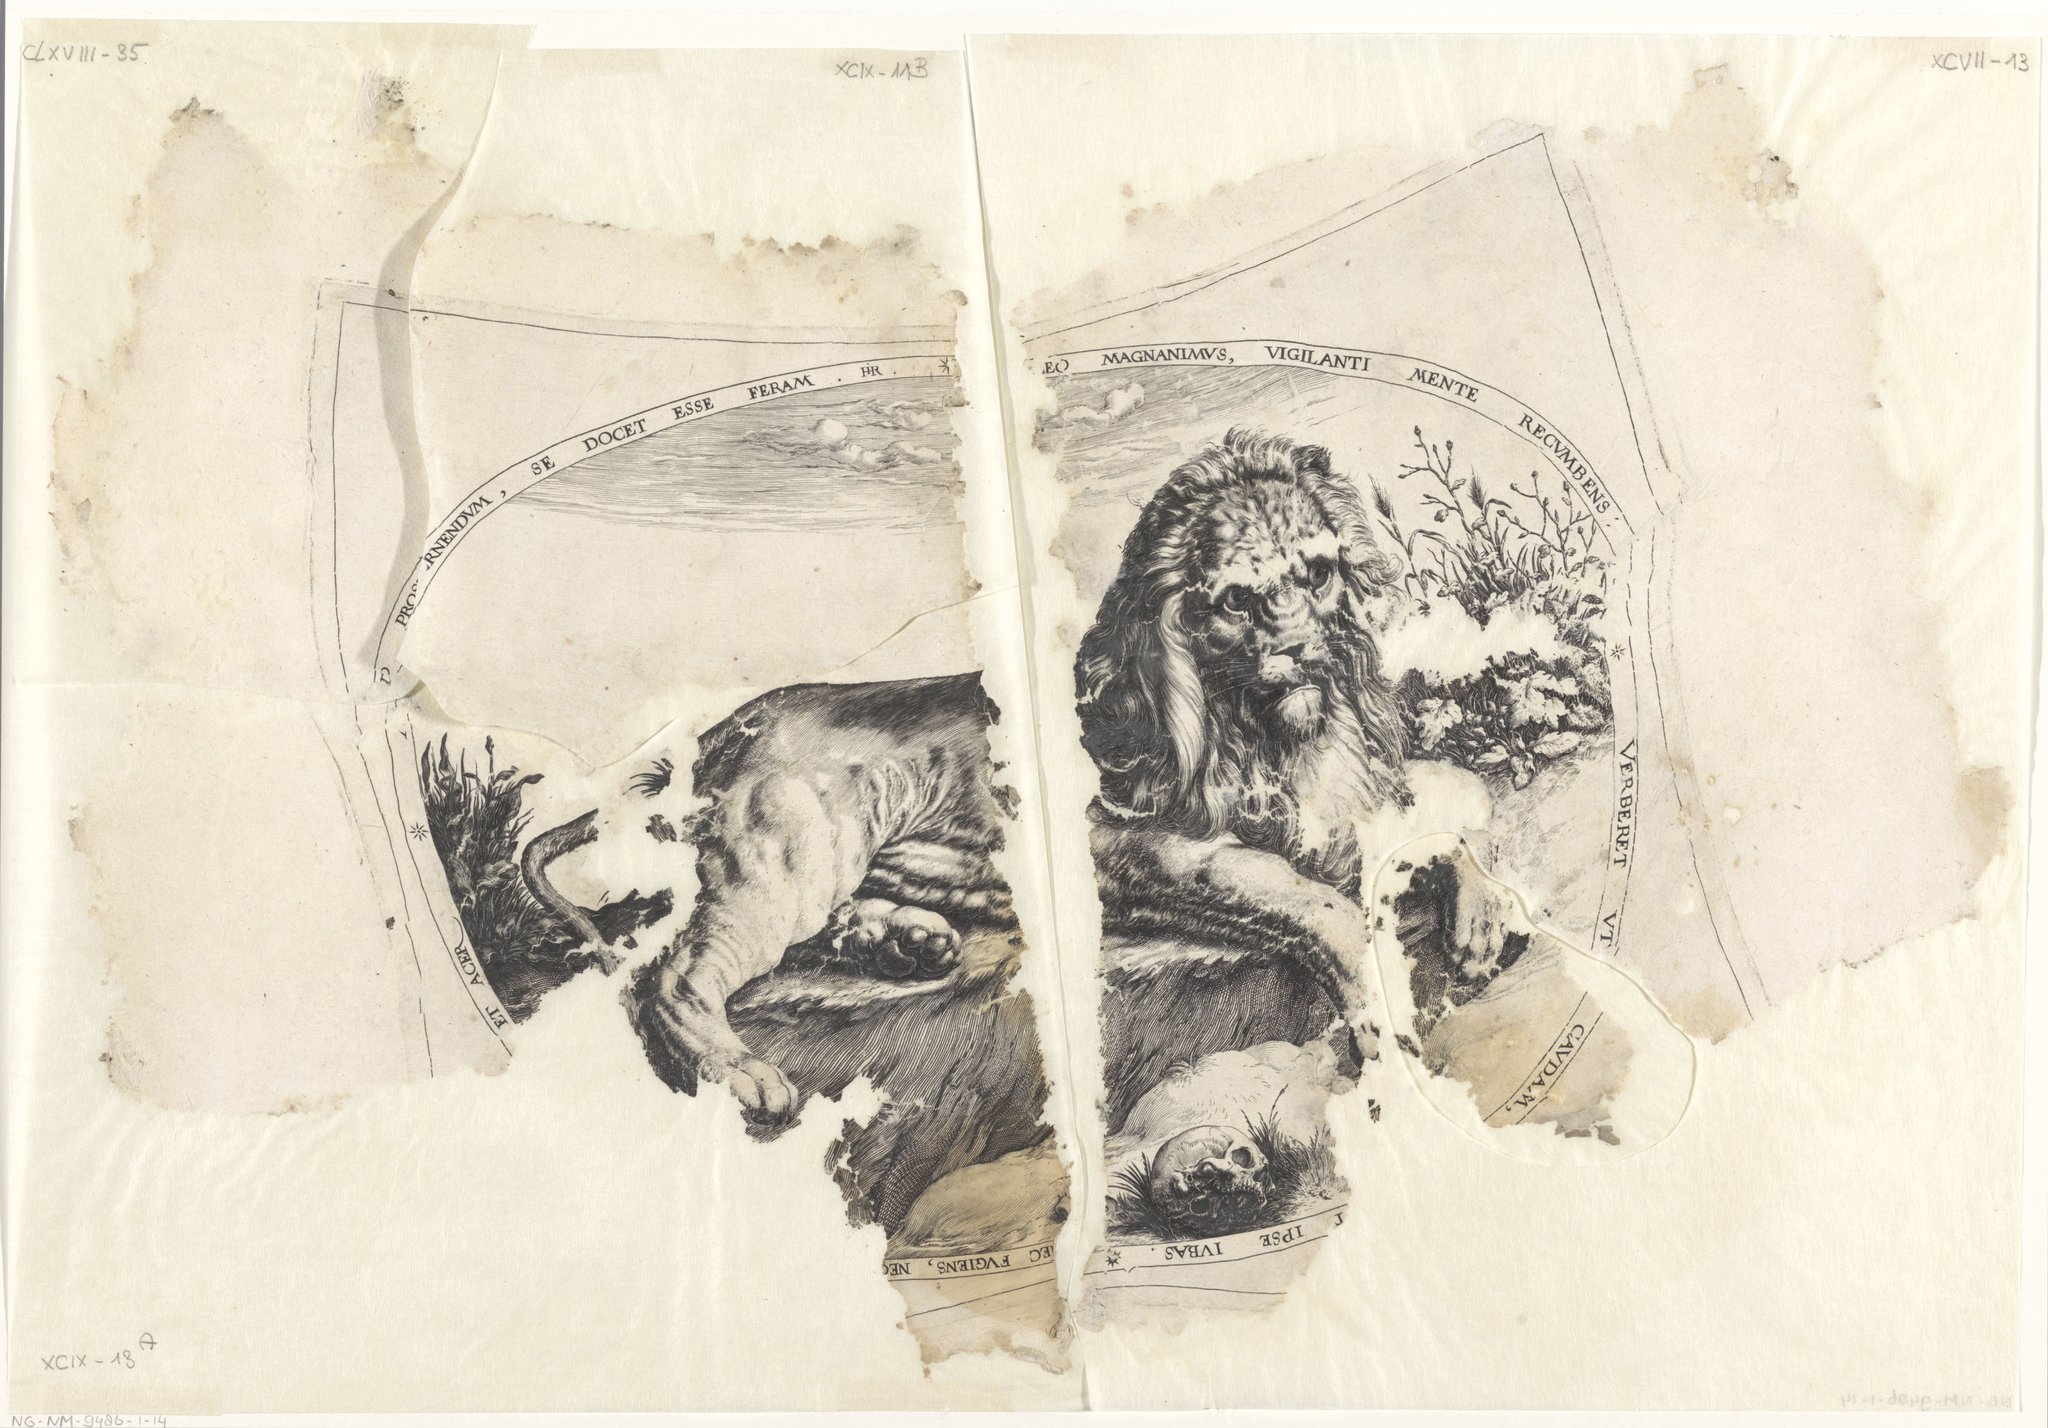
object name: print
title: Leeuw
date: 1580-1596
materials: paper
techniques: engraving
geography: northern netherlands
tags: beasts of prey, predatory animals: lion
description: De prenten in de Nova Zembla collectie zijn tijdens een expeditie van Willem Barendsz en Jacob van Heemskerk in 1596-1597 noodgedwongen in het winterkamp, het ‘Behouden Huis’, op het eiland achtergelaten. De prenten waren in één of meerdere stapels als handelswaar meegenomen vanuit Amsterdam. Bijna drie eeuwen later, in 1871, keerde de Noor Elling Carlsen terug naar Nova Zembla en vond daar de restanten van het ‘Behouden Huis, inclusief een groot deel van de inventaris. Een deel van de prenten, in de vorm van aaneengekoekte kluiten, werd toen ook teruggevonden. De papierkluiten waren soms op meerdere plekken gebroken. Tussen 1975-1979 zijn de prenten van elkaar gescheiden. Dit leverde in totaal ca. 1000 fragmenten van ca. 400 afdrukken van ca. 150 verschillende prenten op. Voor zover mogelijk zijn de fragmenten samengevoegd en zijn de prenten gereconstrueerd.